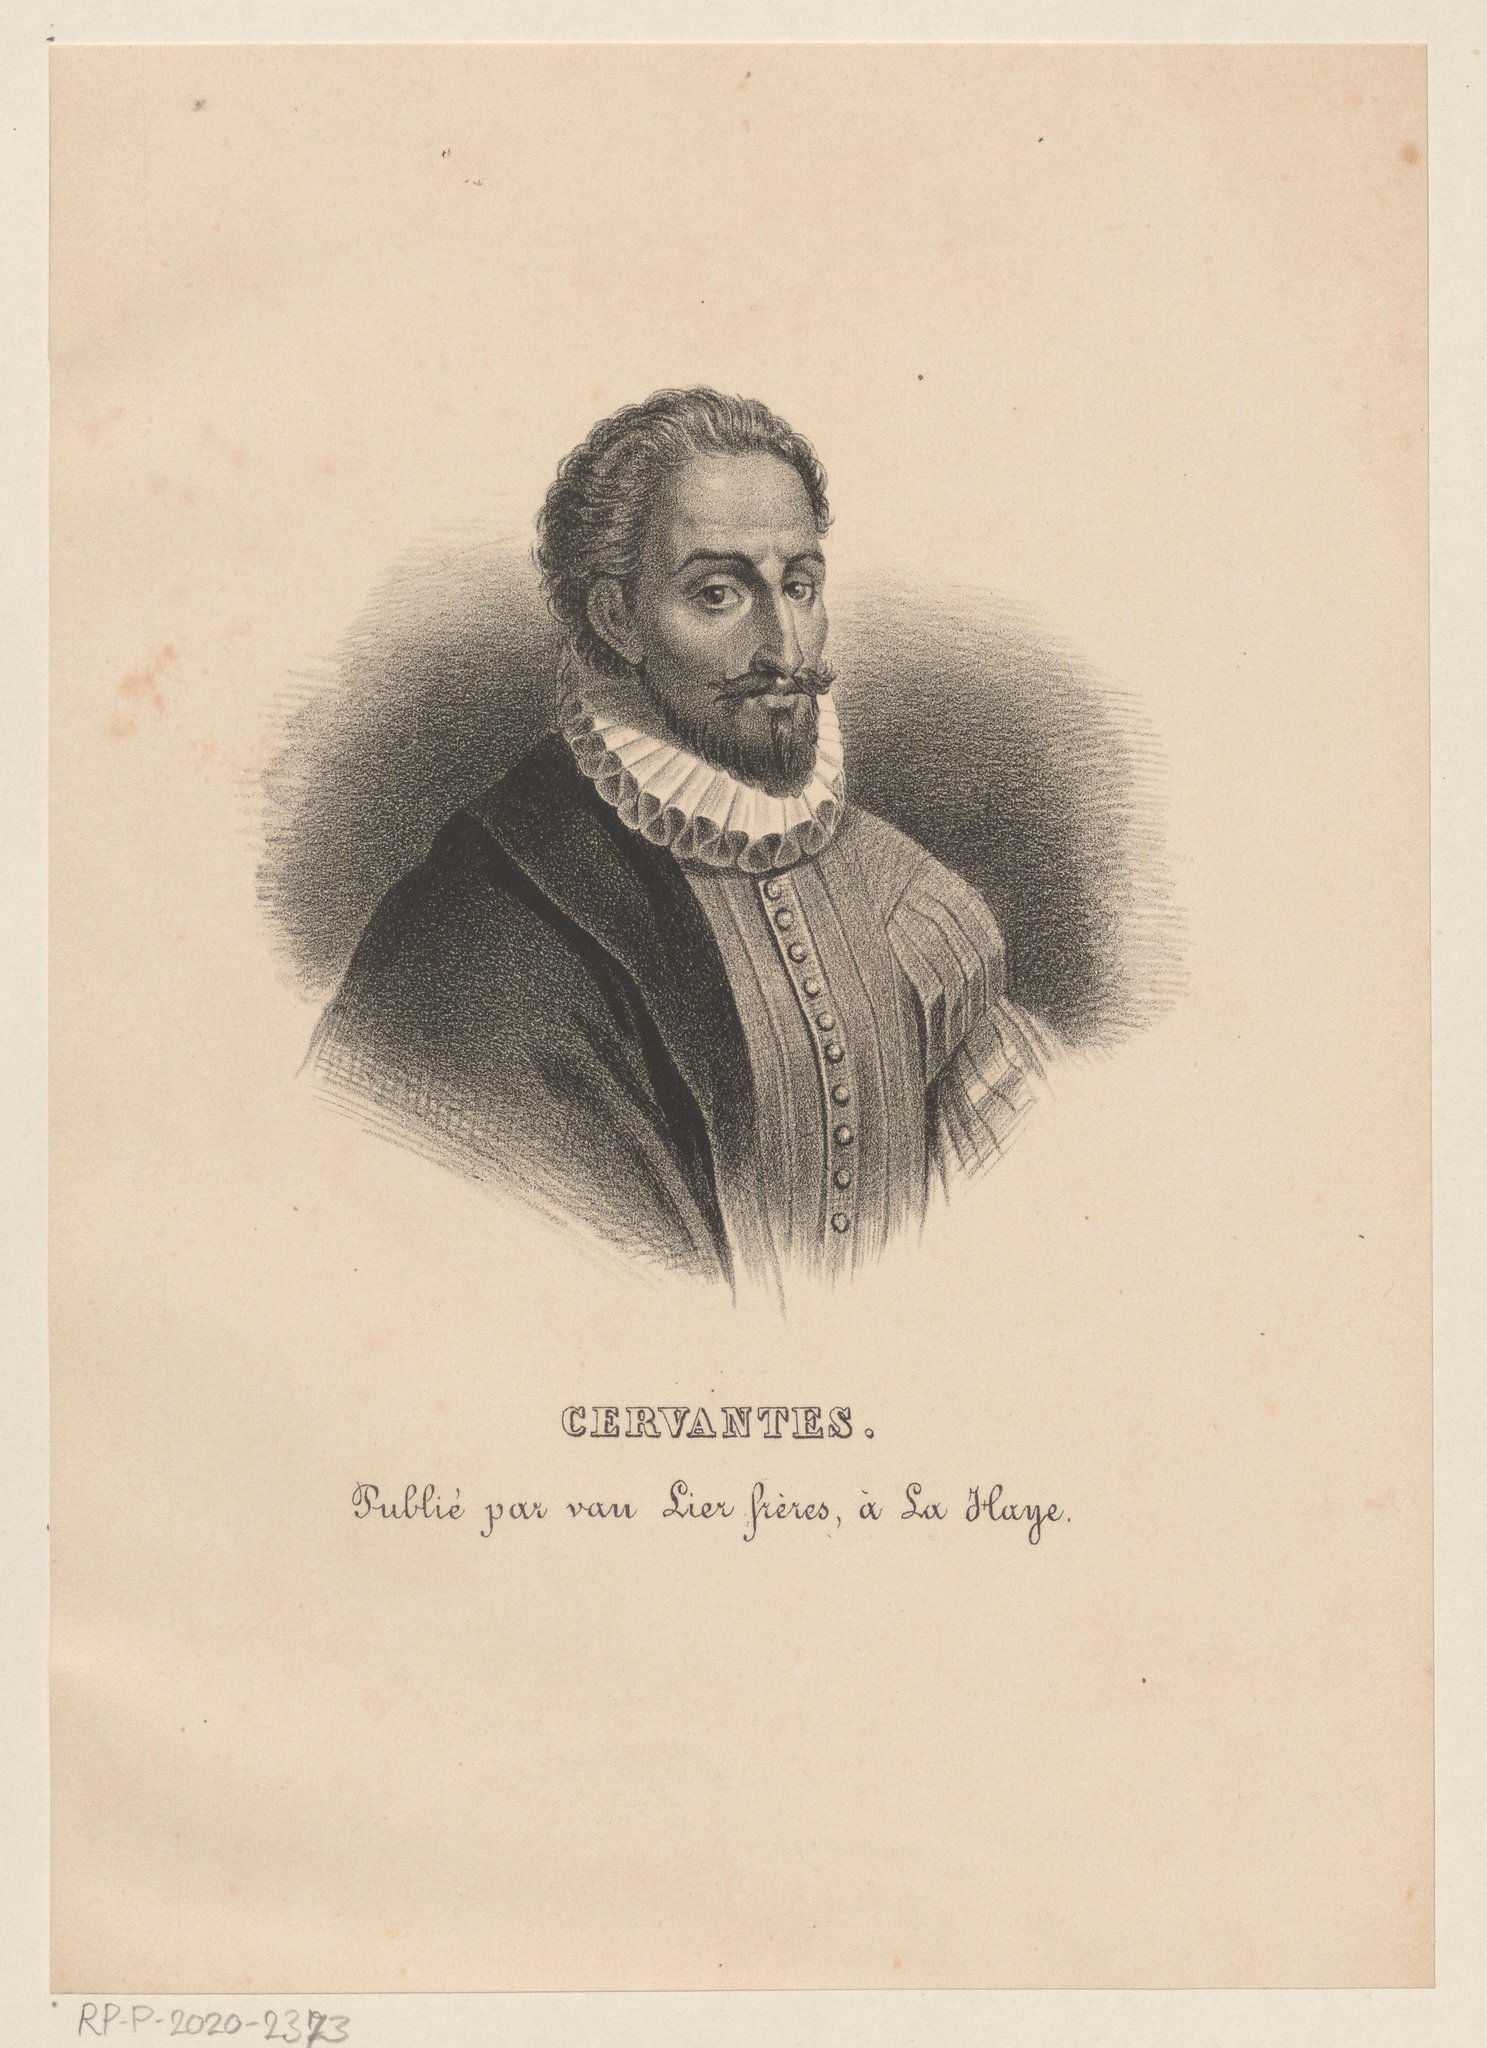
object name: print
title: Portret van Miguel de Cervantes Saavedra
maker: Anonymous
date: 1833-1850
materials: paper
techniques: lithograph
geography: the hague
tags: historical persons